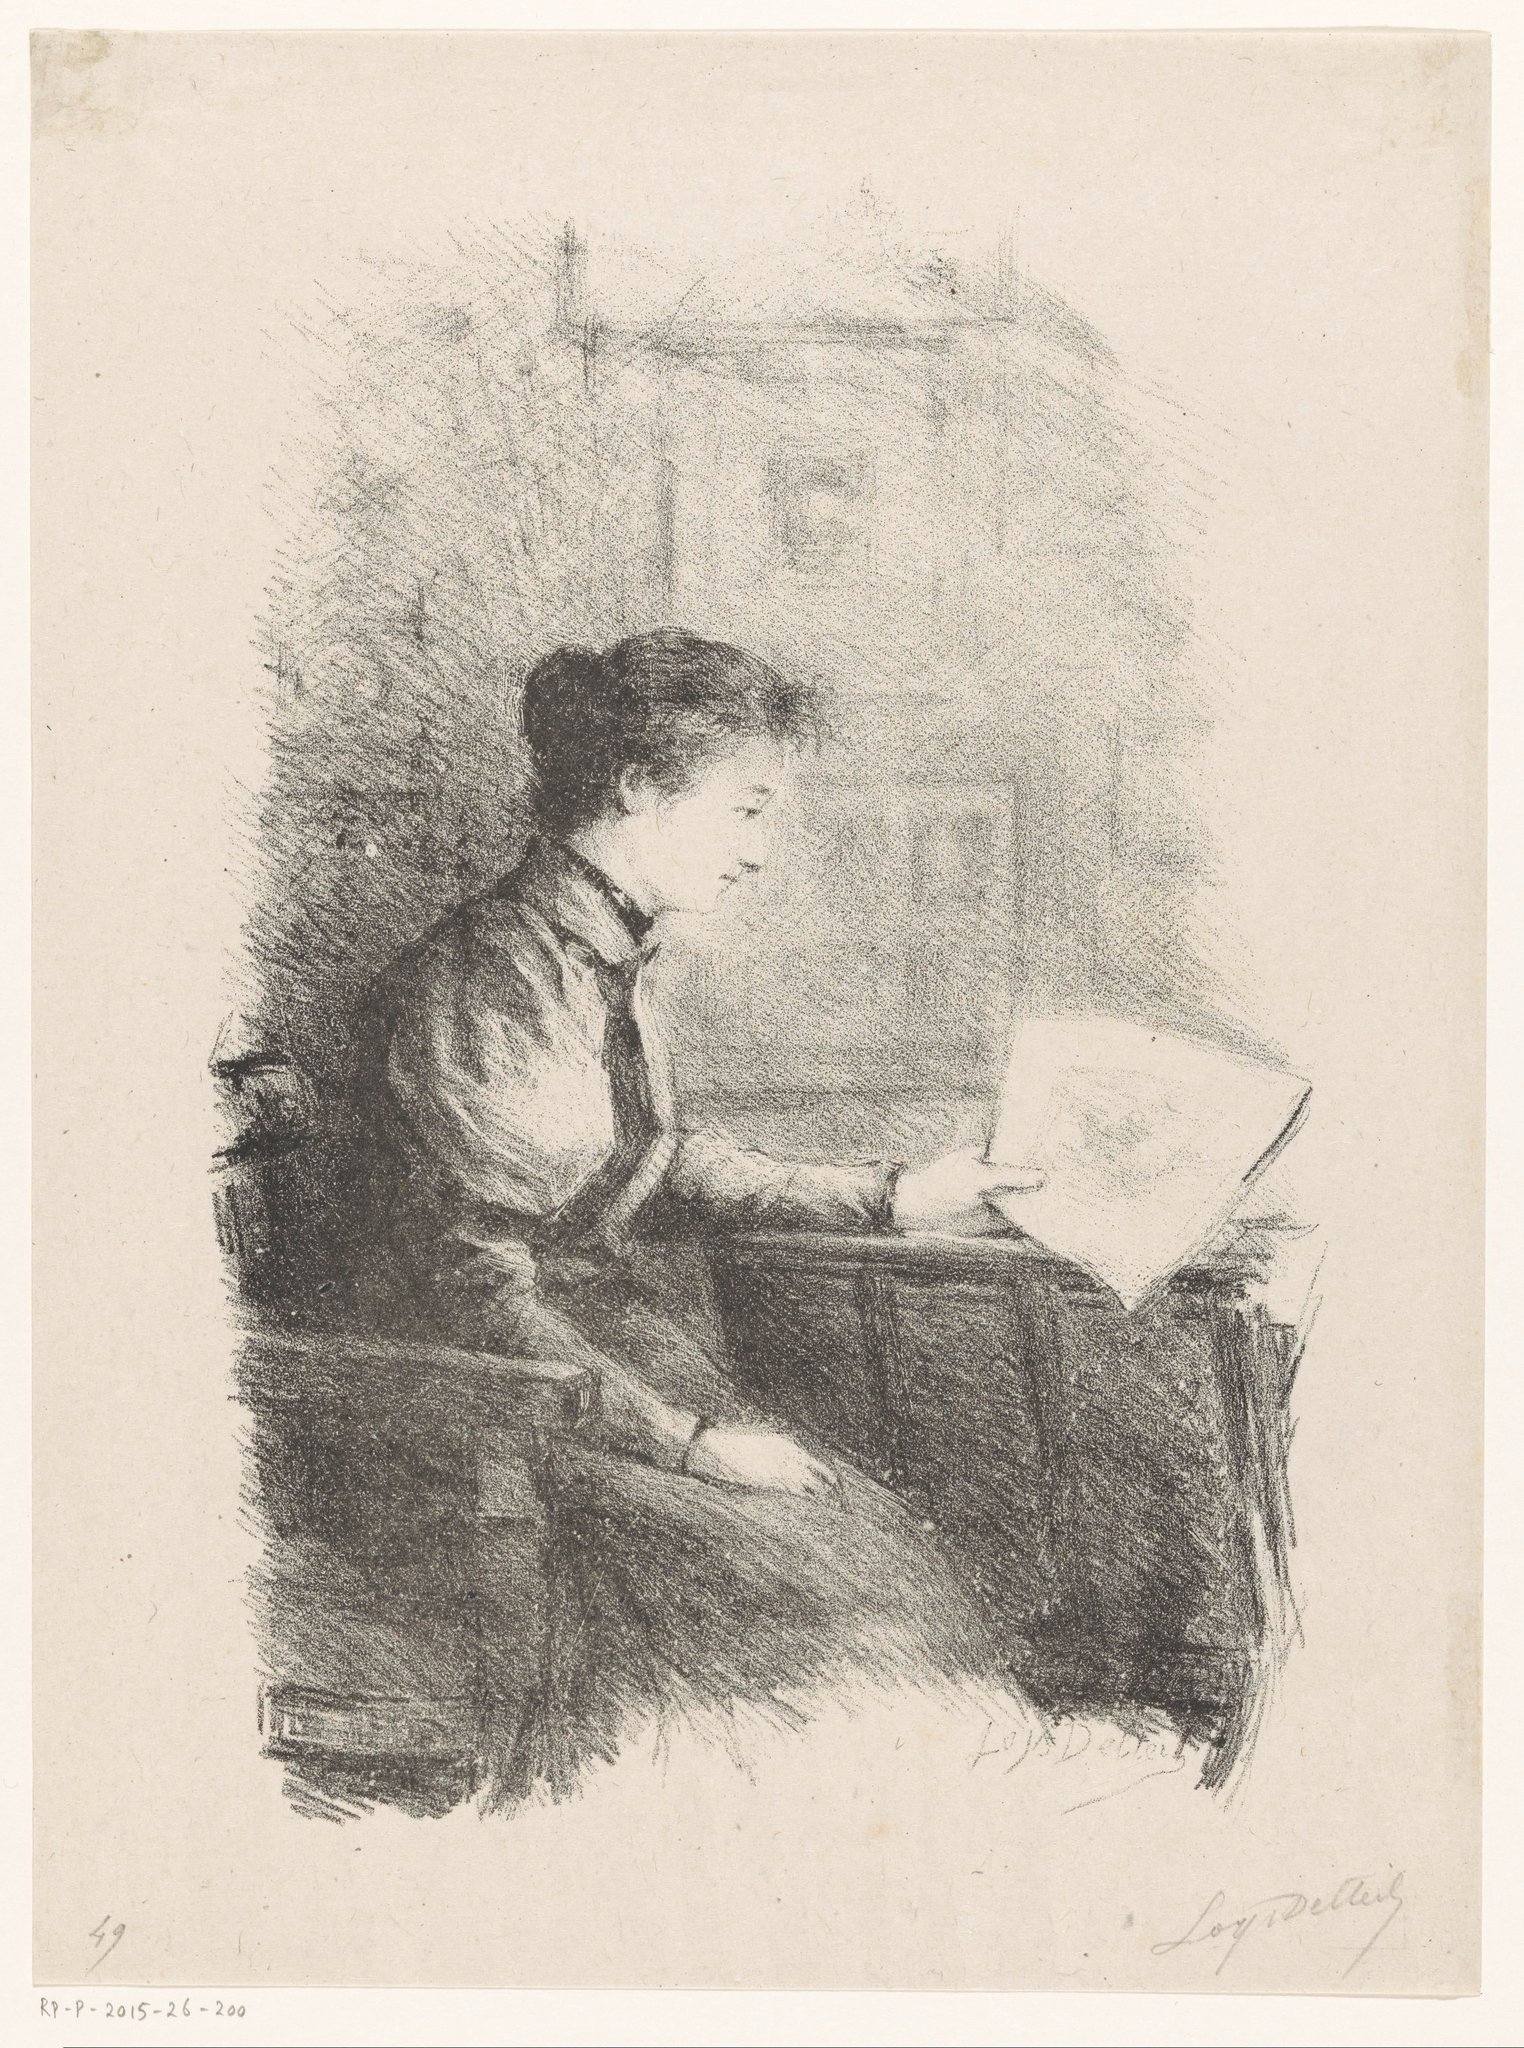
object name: print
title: Zittende vrouw bekijkt een prent of tekening, voor haar een prentstandaard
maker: loys-henry delteil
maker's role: print maker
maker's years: 1869-1927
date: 1879-1927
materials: paper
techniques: lithograph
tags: print, e.g.: engraving, etching, lithograph, art collecting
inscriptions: collector's mark: Lugt 4779, number: ‘49’, annotation: ‘Loys Delteil’, collector's mark: Lugt 2228